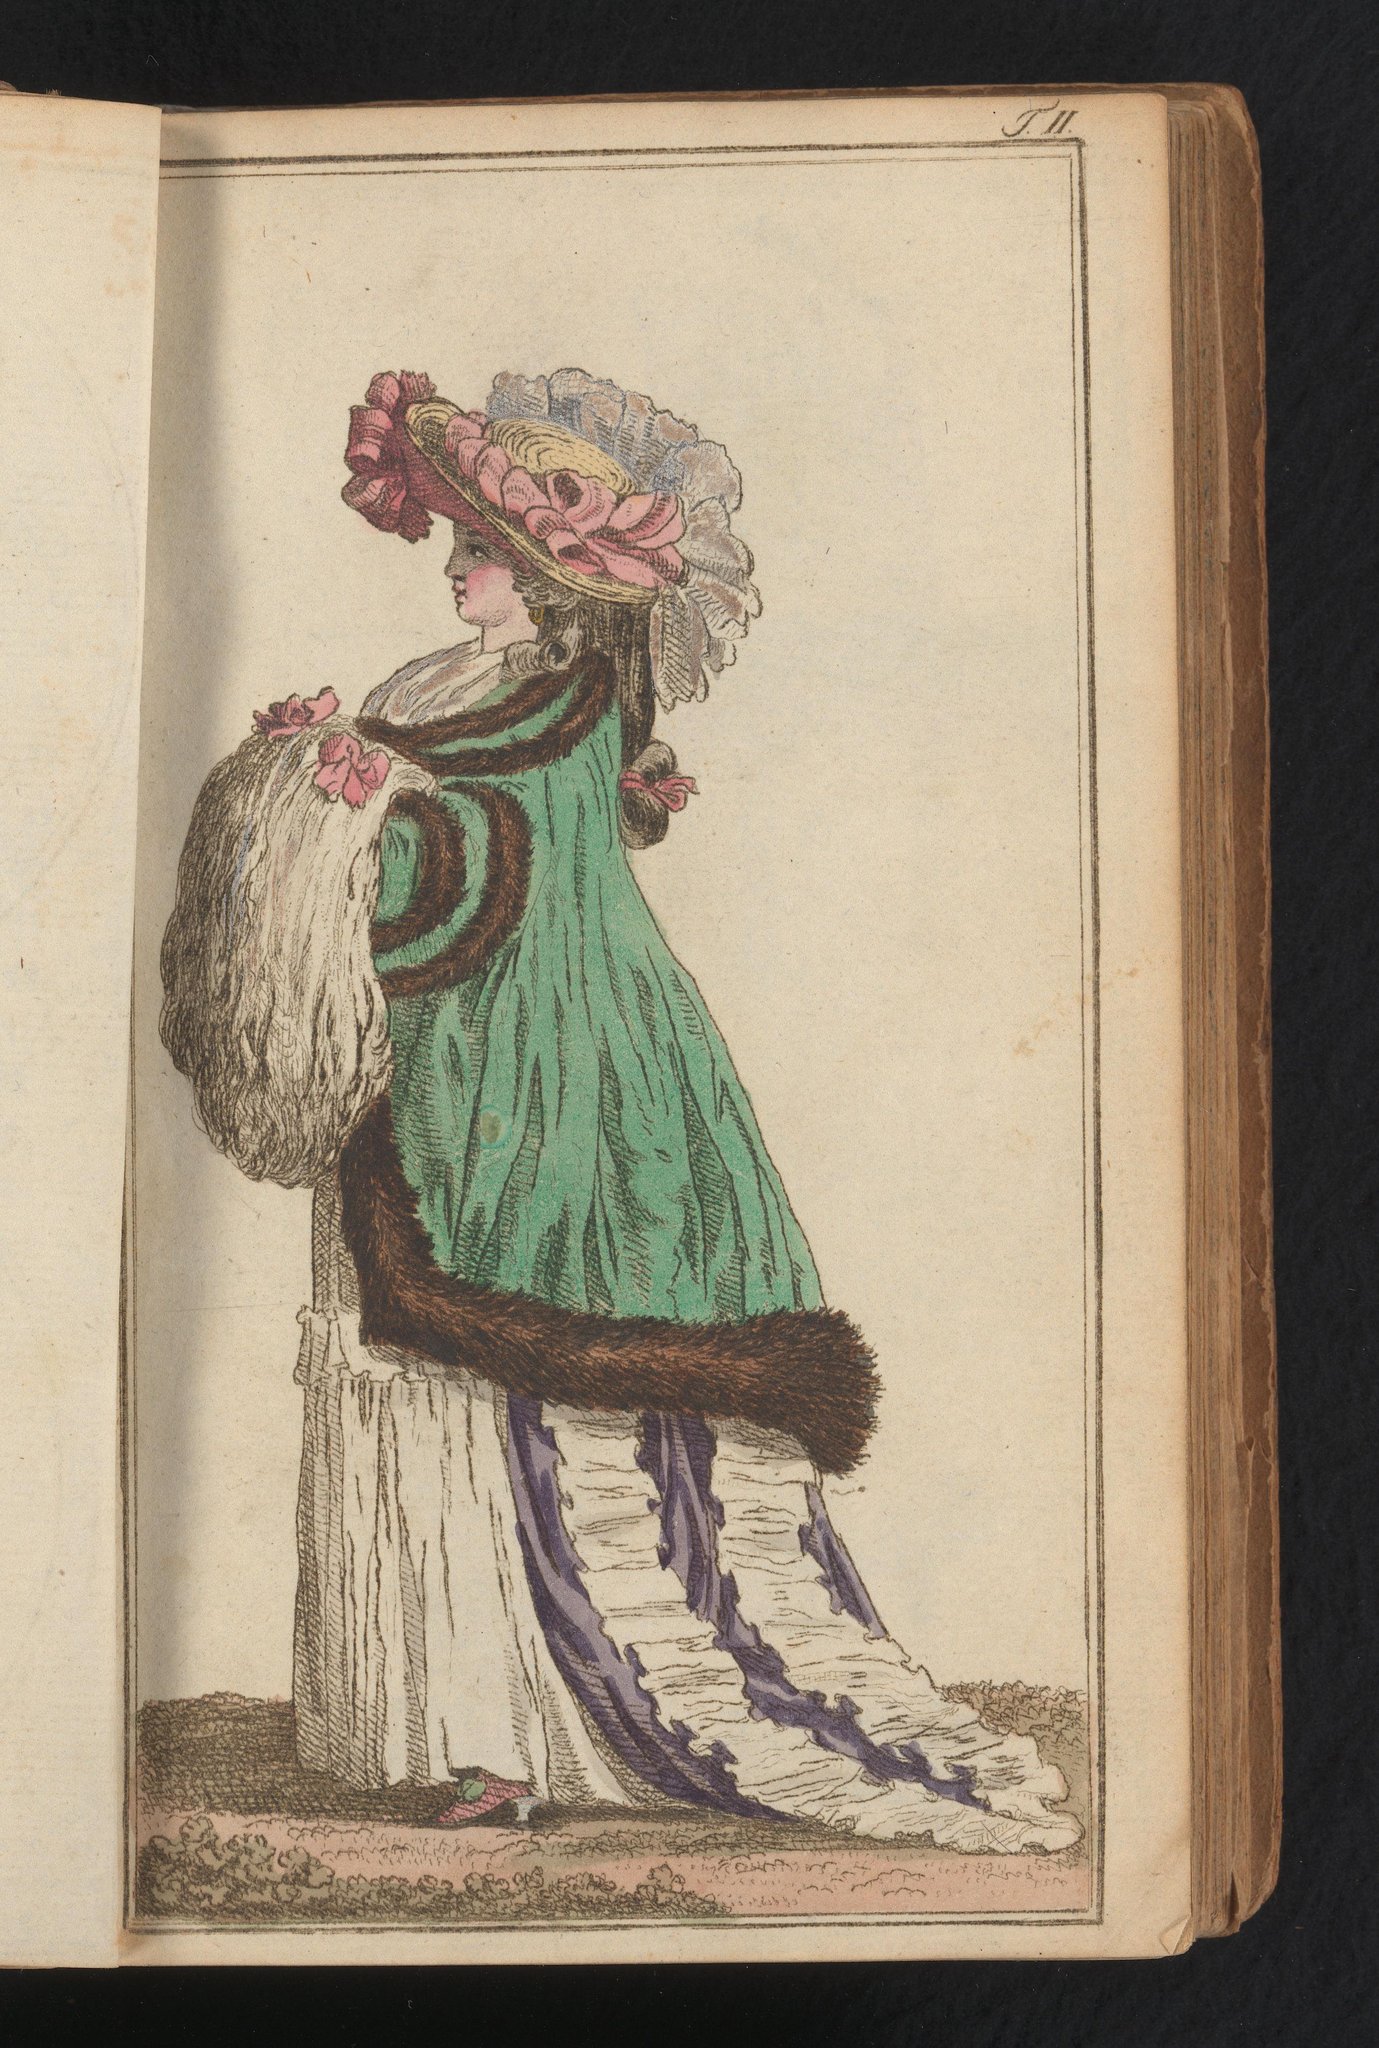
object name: magazine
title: Journal der Moden 1786. T. II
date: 1786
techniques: etching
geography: gotha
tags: fashion plates